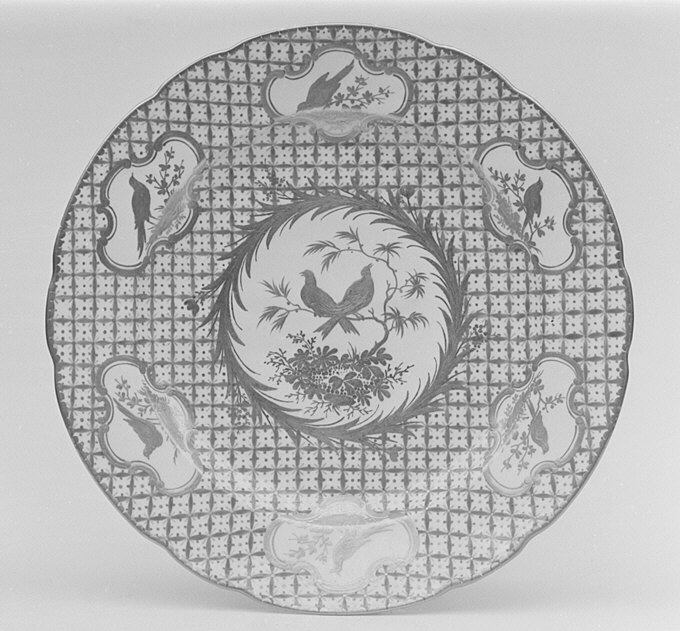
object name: plate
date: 1801-1900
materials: hard paste porcelain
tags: birds